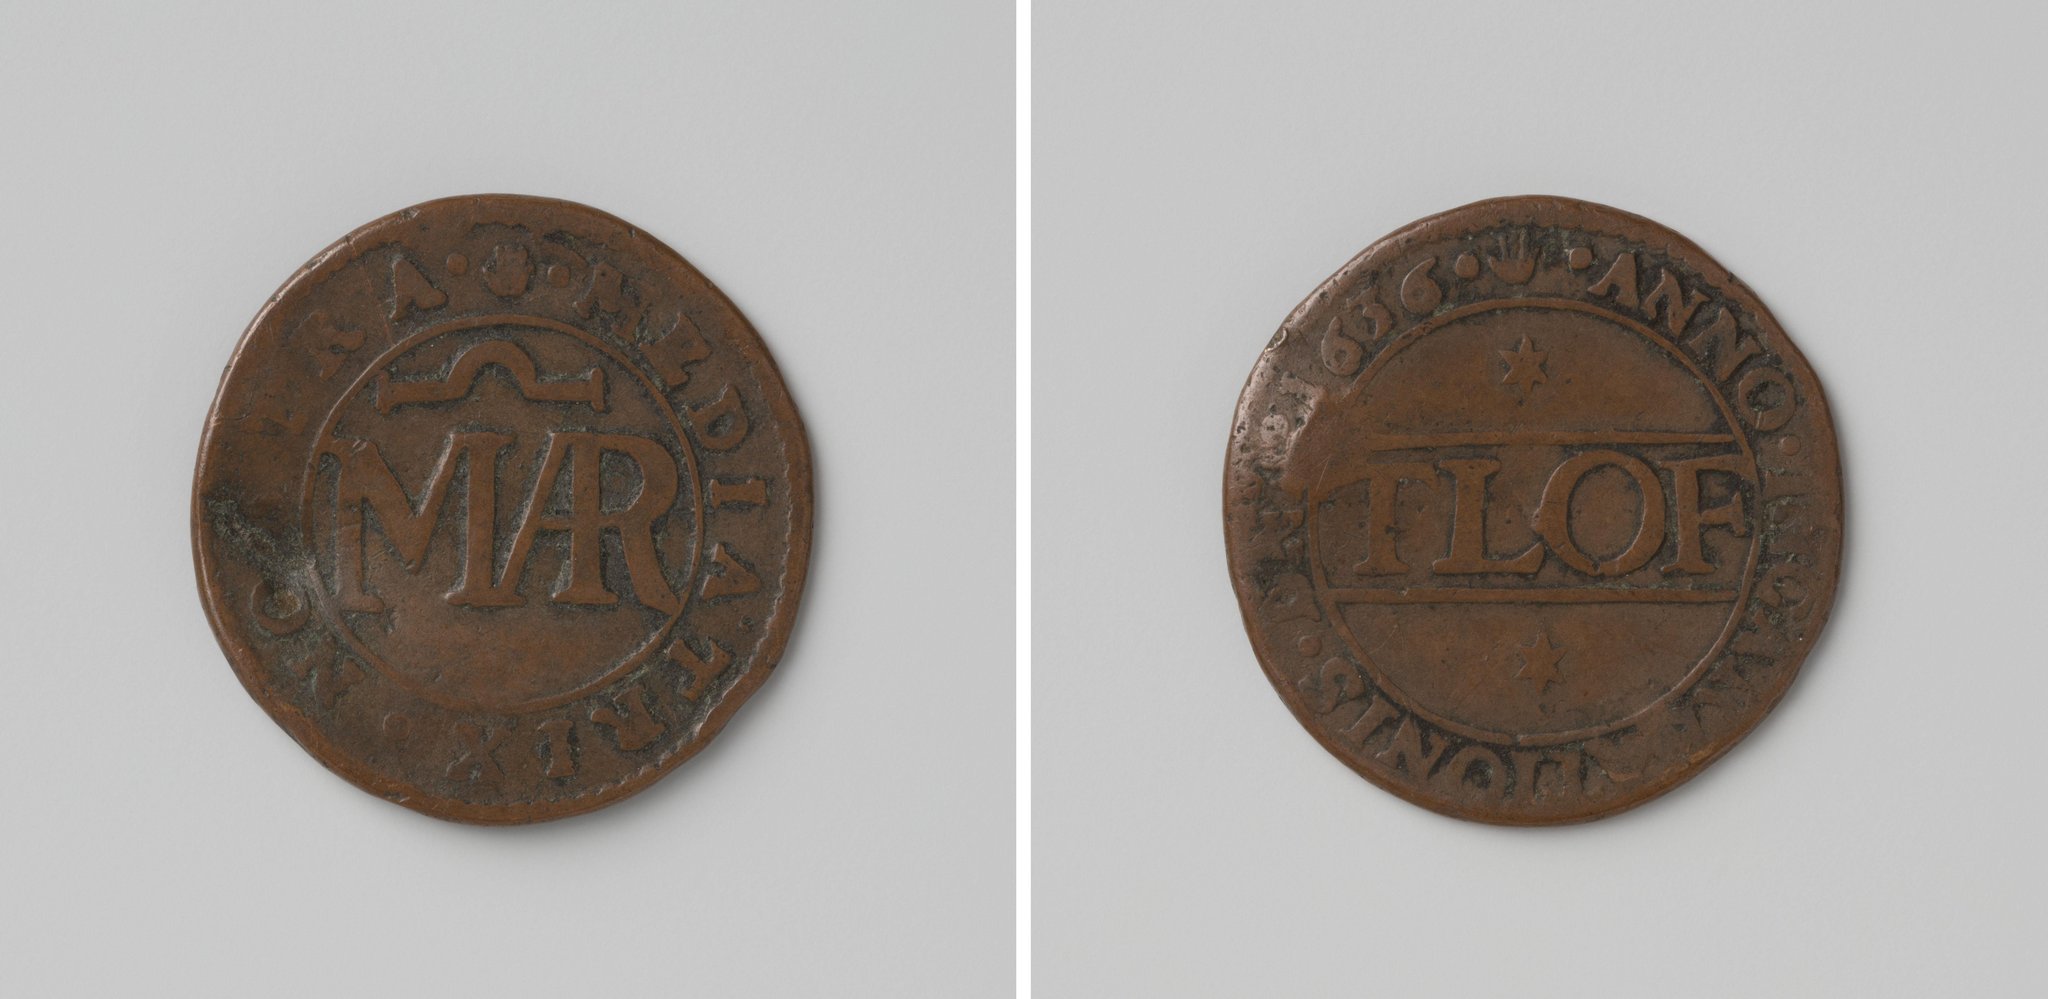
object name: devotional medal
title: Voorspoed van de kapel van de Heilige Maagd te Antwerpen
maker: Anonymous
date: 1636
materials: copper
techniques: striking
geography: antwerp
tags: antwerp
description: Koperen penning. Voorzijde: monogram van letters MAR binnen omschrift. Keerzijde: band met opschrift TLOF; onder en boven een ster binnen omschrift